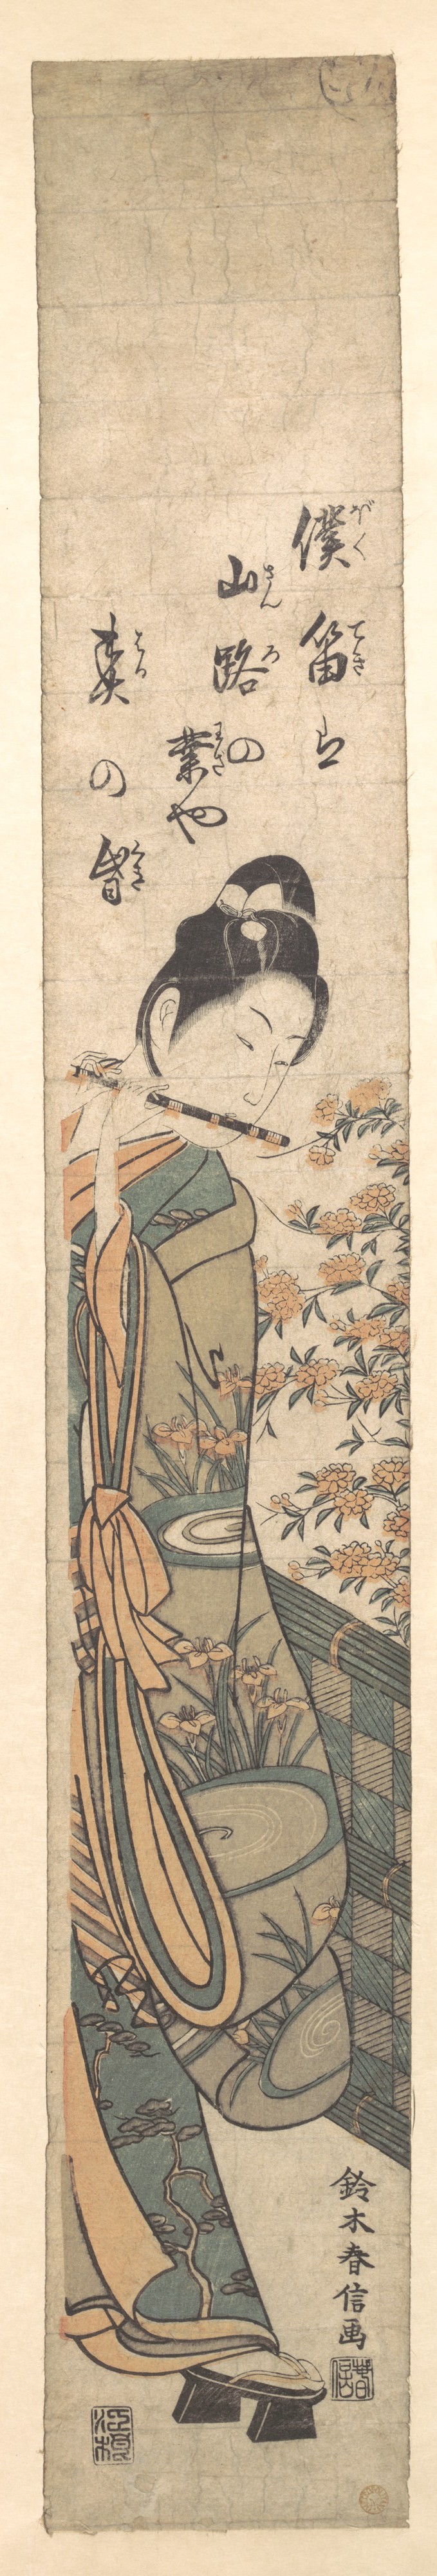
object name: print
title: A Young Man Standing before a Garden Fence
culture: japanese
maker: suzuki harunobu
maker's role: artist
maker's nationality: japanese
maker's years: 1725-1770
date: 1763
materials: ink, paper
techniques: woodblock print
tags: men,flutes,flowers